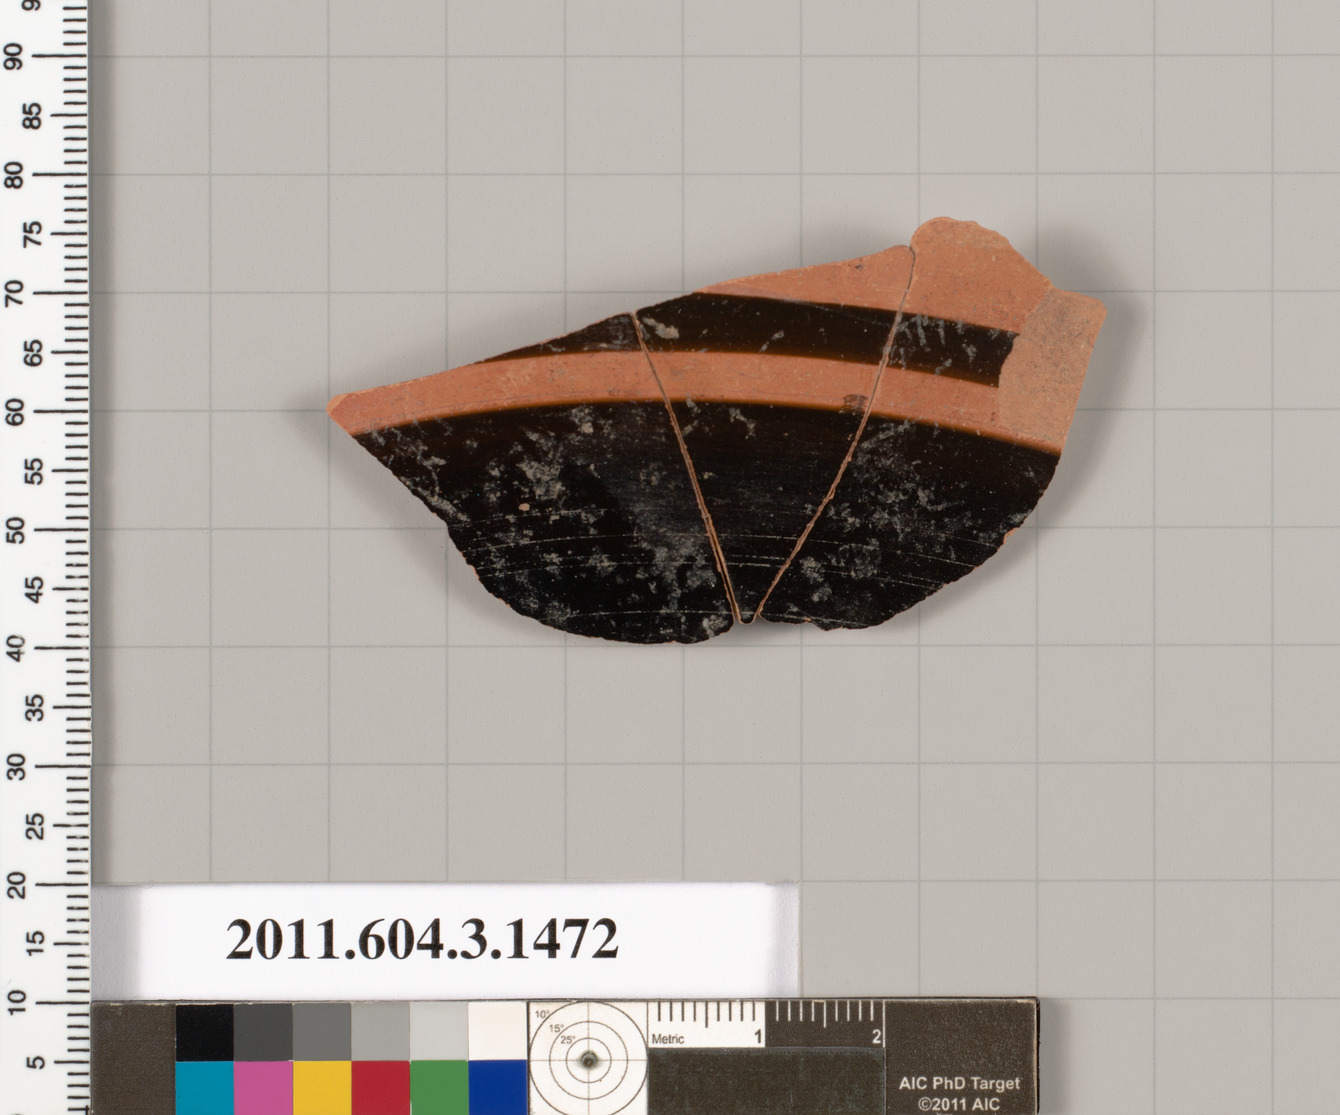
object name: skyphos fragment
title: Terracotta fragment of a skyphos (deep drinking cup)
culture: greek, attic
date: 600-401 BCE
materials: terracotta